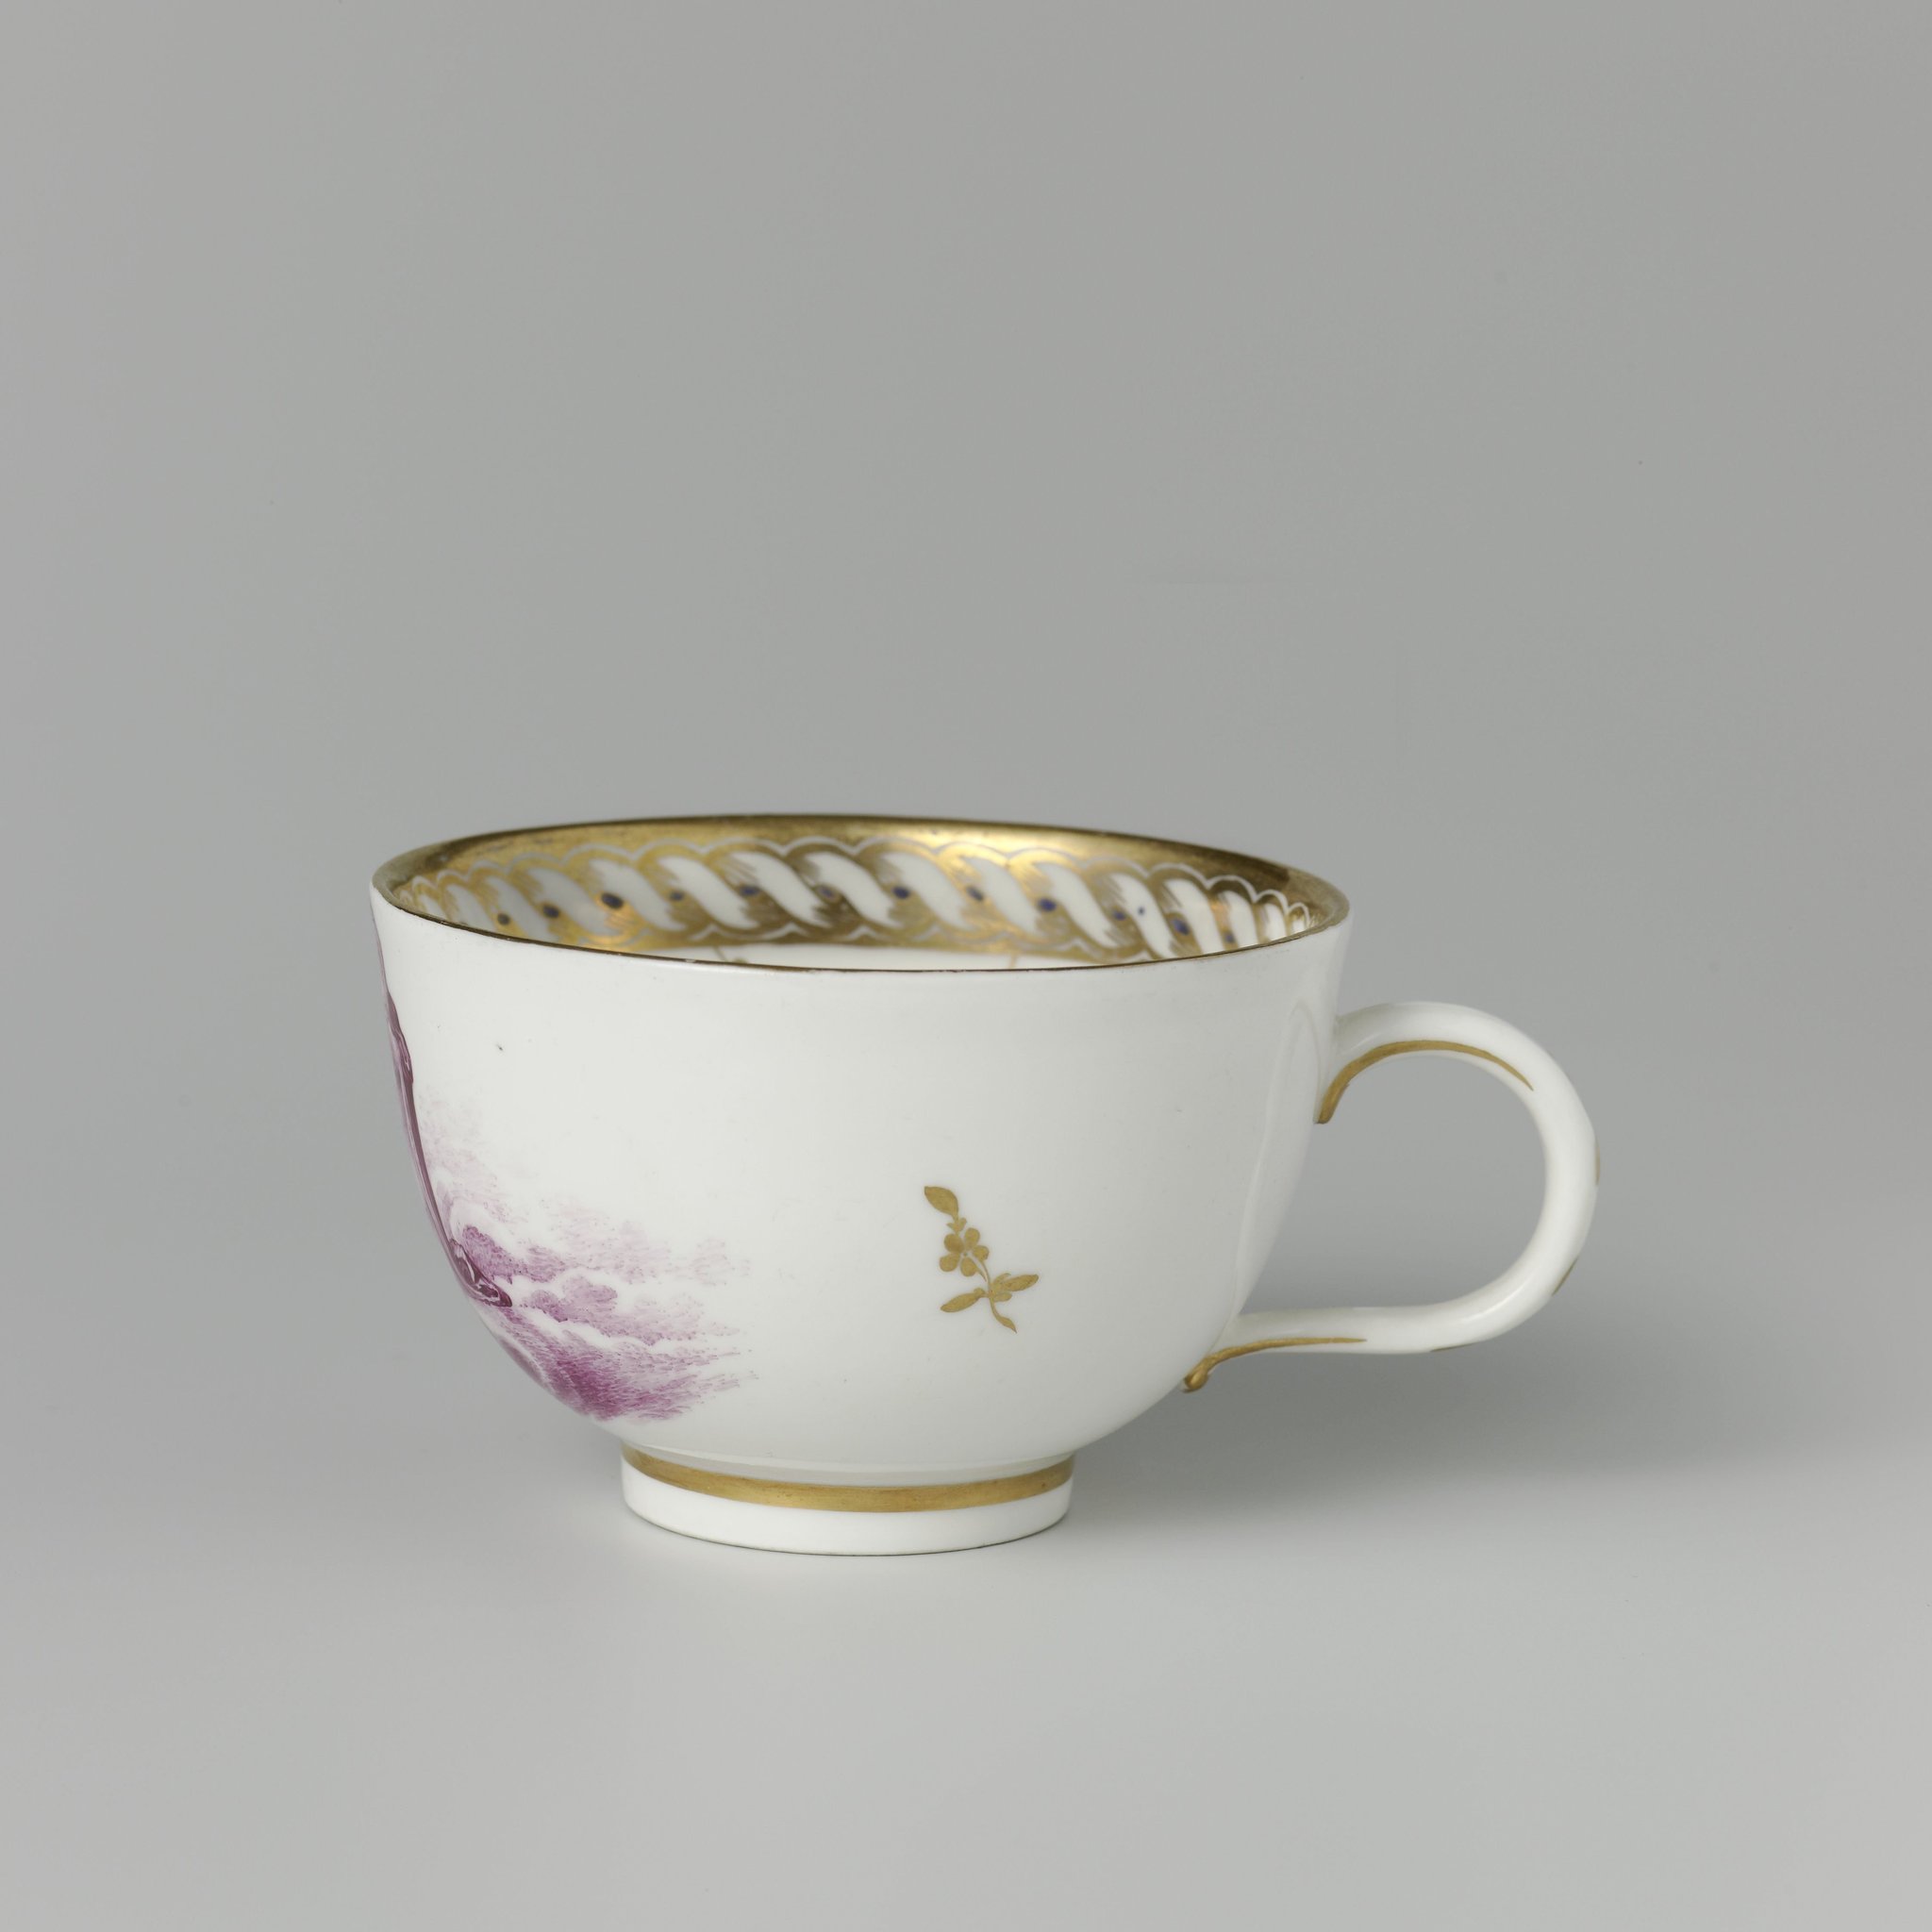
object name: service set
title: Cup with a putto on clouds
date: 1785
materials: glaze, gold, paint, porcelain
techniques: firing, forming, gilding, turning, vitrification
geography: the hague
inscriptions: mark: ‘ooievaar’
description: Kop (theekop) van porselein met een C-vormig oor, beschilderd op het glazuur in roze (camaïeu) en goud. Op de buitenwand een putto op een wolk. Hij is gewikkeld in een doek en leunt tegen een voetstuk waarop een vaas staat. Om de voorstelling strooibloemen in goud. De binnenrand met een gedraaide band, waaraan guirlandes en bloemtakken hangen. Gouden lijn op de voet en gouden rand. Gemerkt op de onderzijde met de ooievaar.